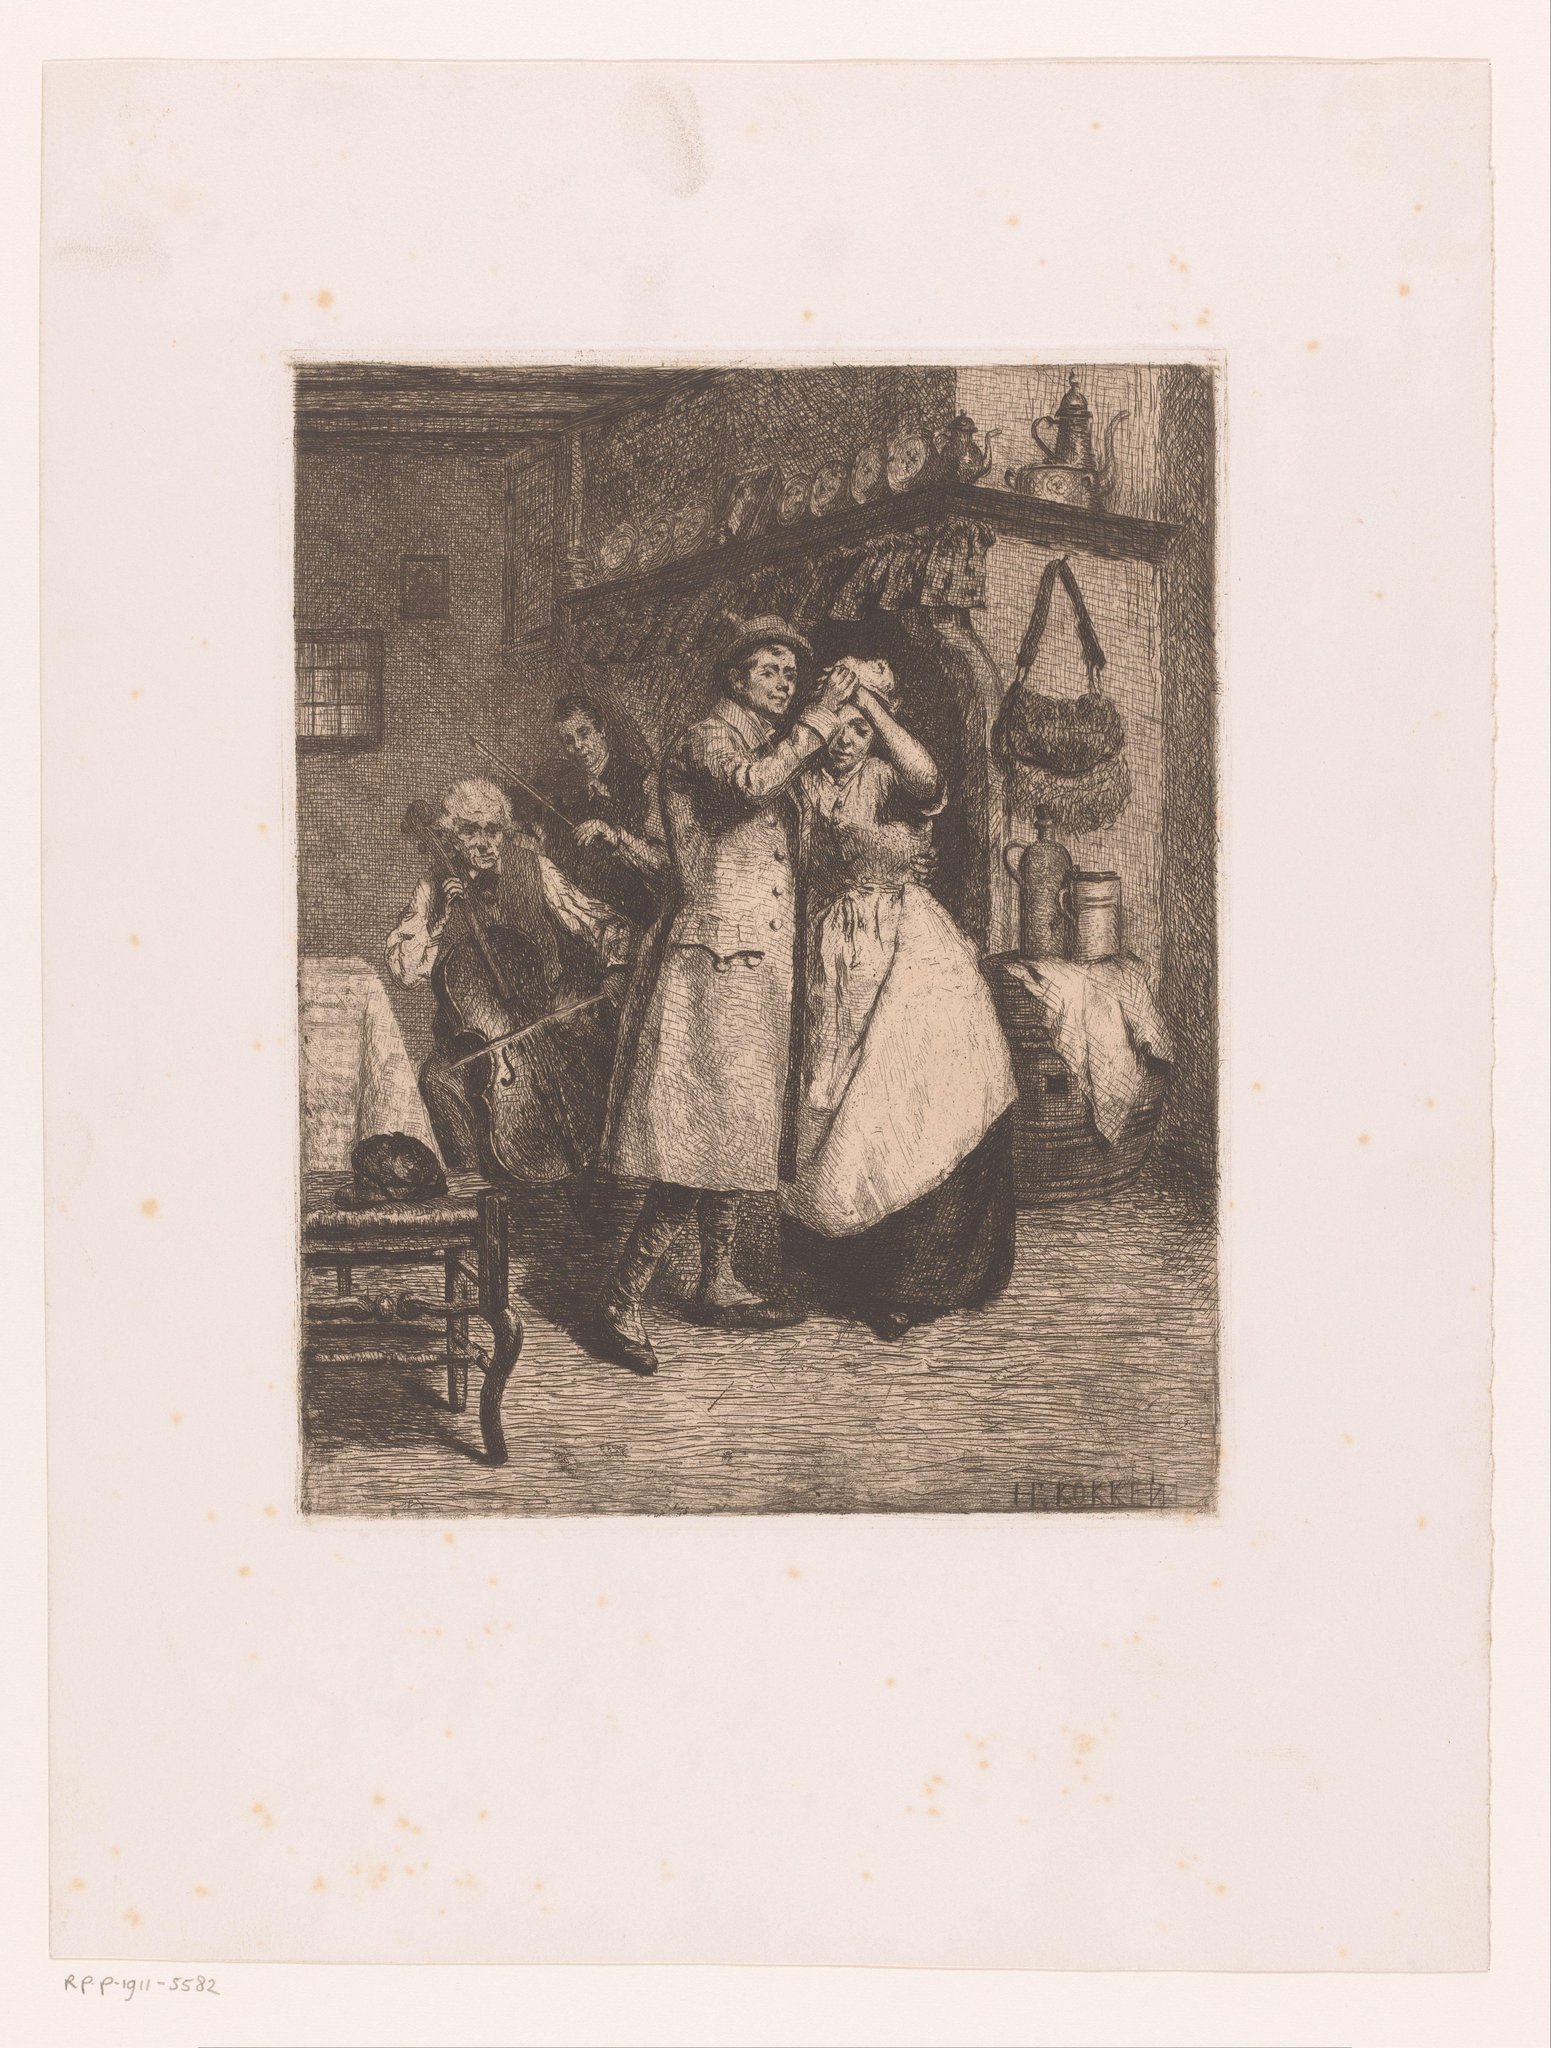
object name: print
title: Man en een vrouw dansen onder leiding van muzikanten voor een haard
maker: henri kokken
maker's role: print maker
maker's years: 1860-1941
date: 1870-1911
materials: paper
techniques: etching, intaglio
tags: small group of musicians, chamber orchestra, jazz band, one pair dancing; man and woman dancing as a couple, open hearth, fire-place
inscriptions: collector's mark: Lugt 2228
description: Prent vervaardigd naar een detail uit een schilderij van Henri Kokken, ook wel getiteld "Walsje in de herberg".